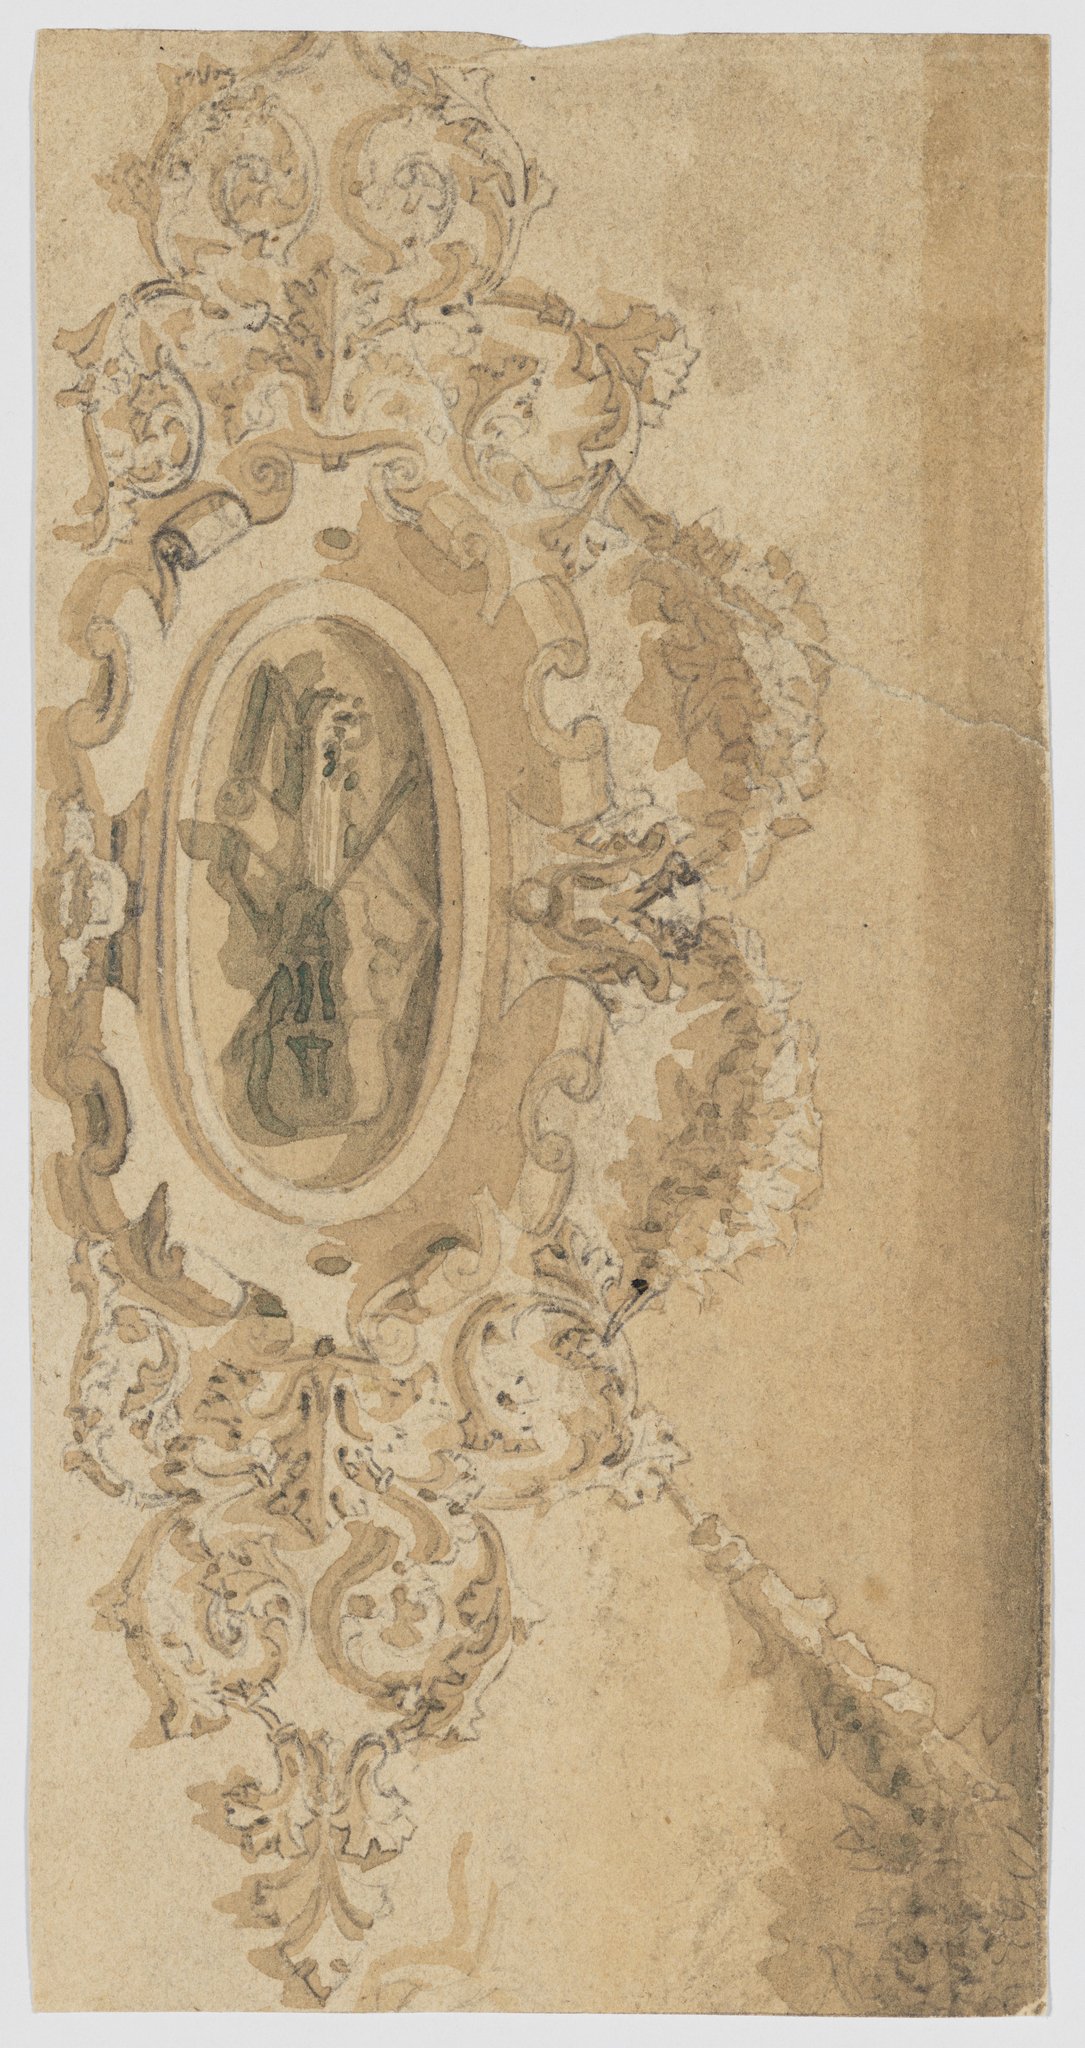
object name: drawing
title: Design for a Cartouche with a Violin and Scrolls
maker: anonymous, french, 19th century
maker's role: artist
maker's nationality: french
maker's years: 1800-1900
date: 1801-1833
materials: ink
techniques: brush, pen, wash